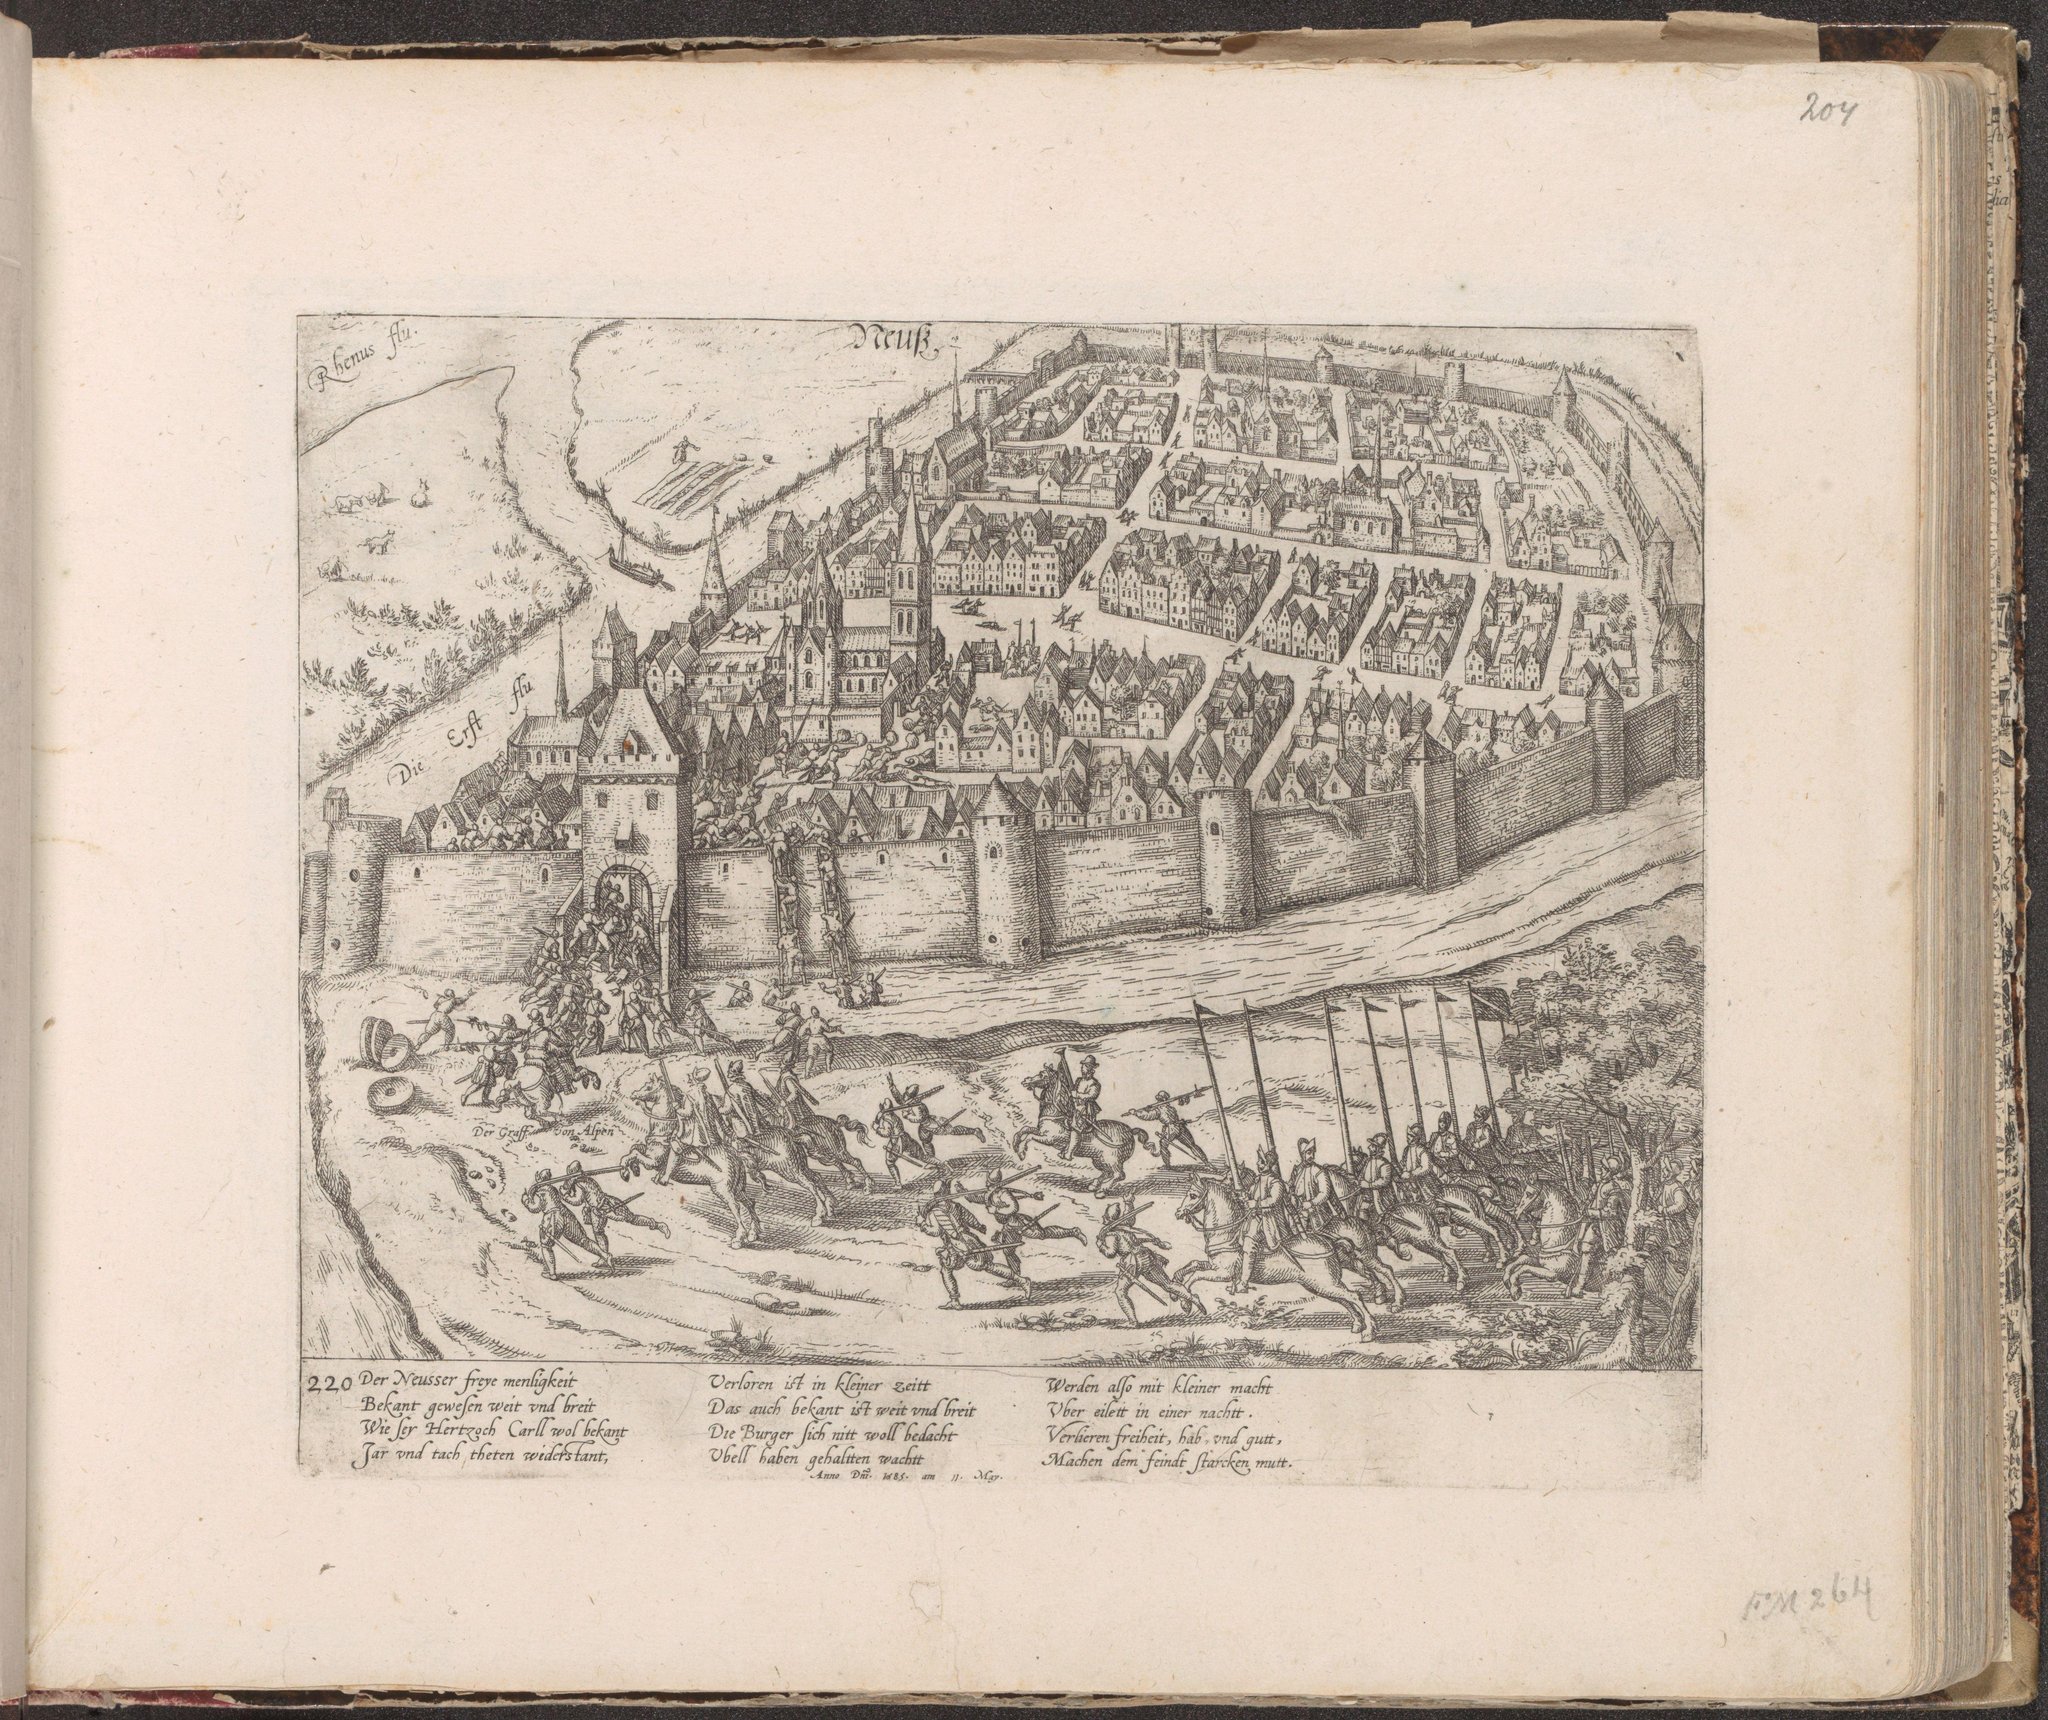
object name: print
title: Serie 9: Nederlandse en Duitse Gebeurtenissen, 1583-1587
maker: frans hogenberg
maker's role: print maker, publisher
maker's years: 1538-1590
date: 1587-1591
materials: paper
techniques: etching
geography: cologne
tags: capture of city (after the siege)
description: Inname van Neuss, 11 mei 1585. Met onderschrift van 12 regels in het Duits. Linksonder genummerd: 220. De prent maakt deel uit van een album.